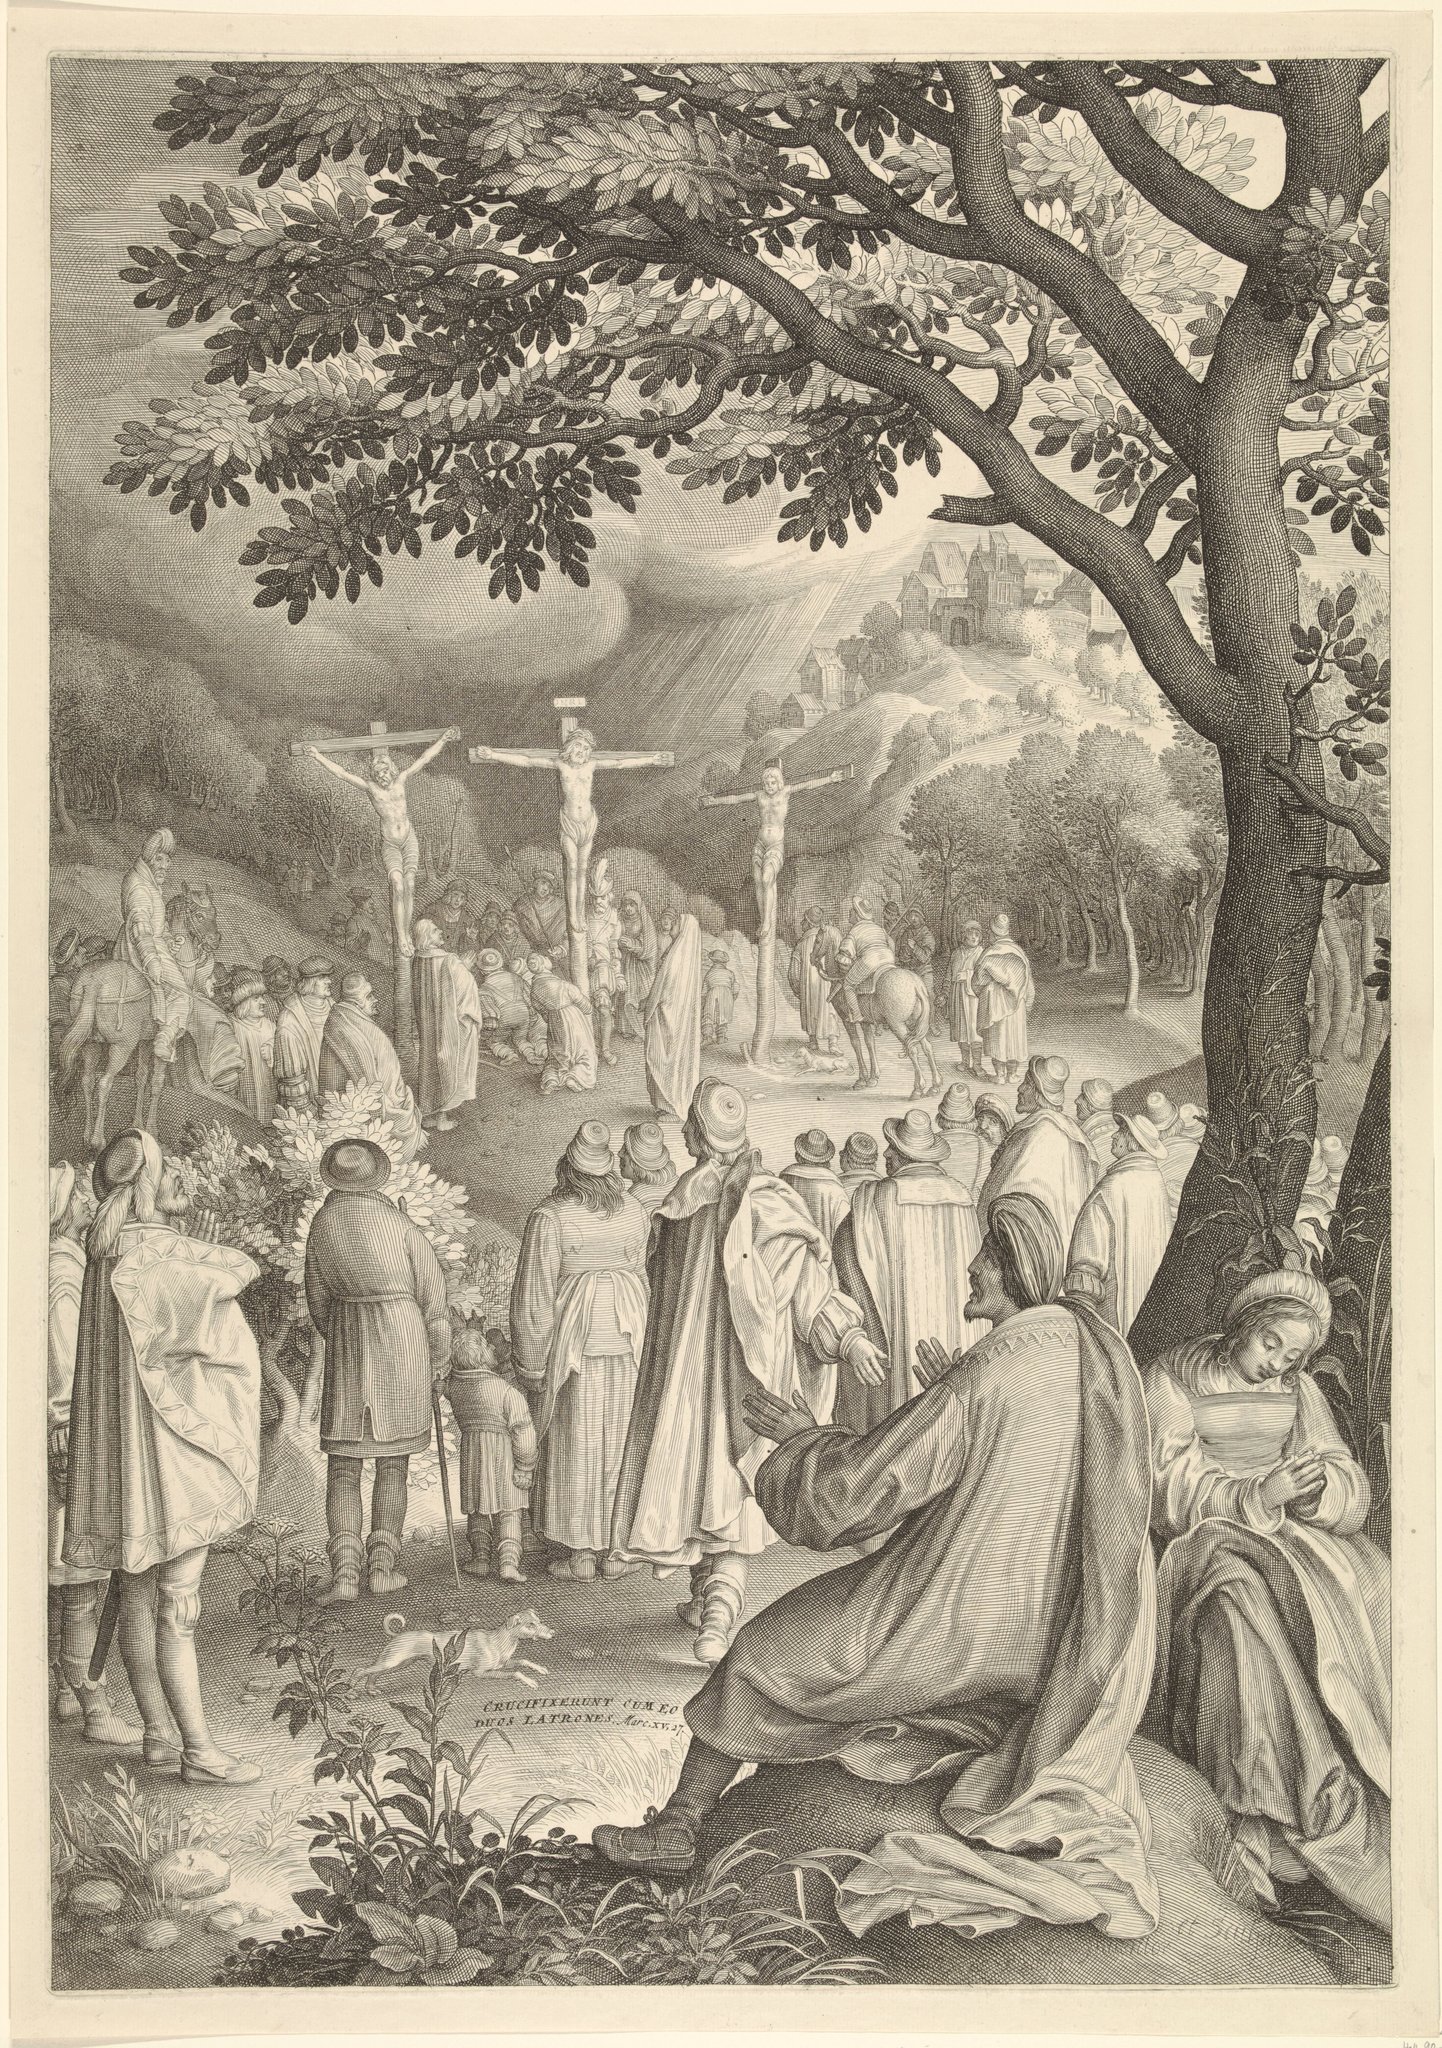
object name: print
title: Christus aan het kruis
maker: nicolaes de bruyn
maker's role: print maker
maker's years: 1571-1656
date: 1637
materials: paper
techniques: engraving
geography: rotterdam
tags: crucified christ with mary, john, and mary magdalene, the crucifixion of christ: christ's death on the cross; golgotha (matthew 27:45-58; mark 15:33-45; luke 23:44-52; john 19:25-38)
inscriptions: date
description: De kruisdood van Christus op de berg Golgota. Links en rechts van hem de misdadigers die samen met hem gekruisigd zijn. Maria, Maria Magdalena en de apostel Johannes onder het kruis.